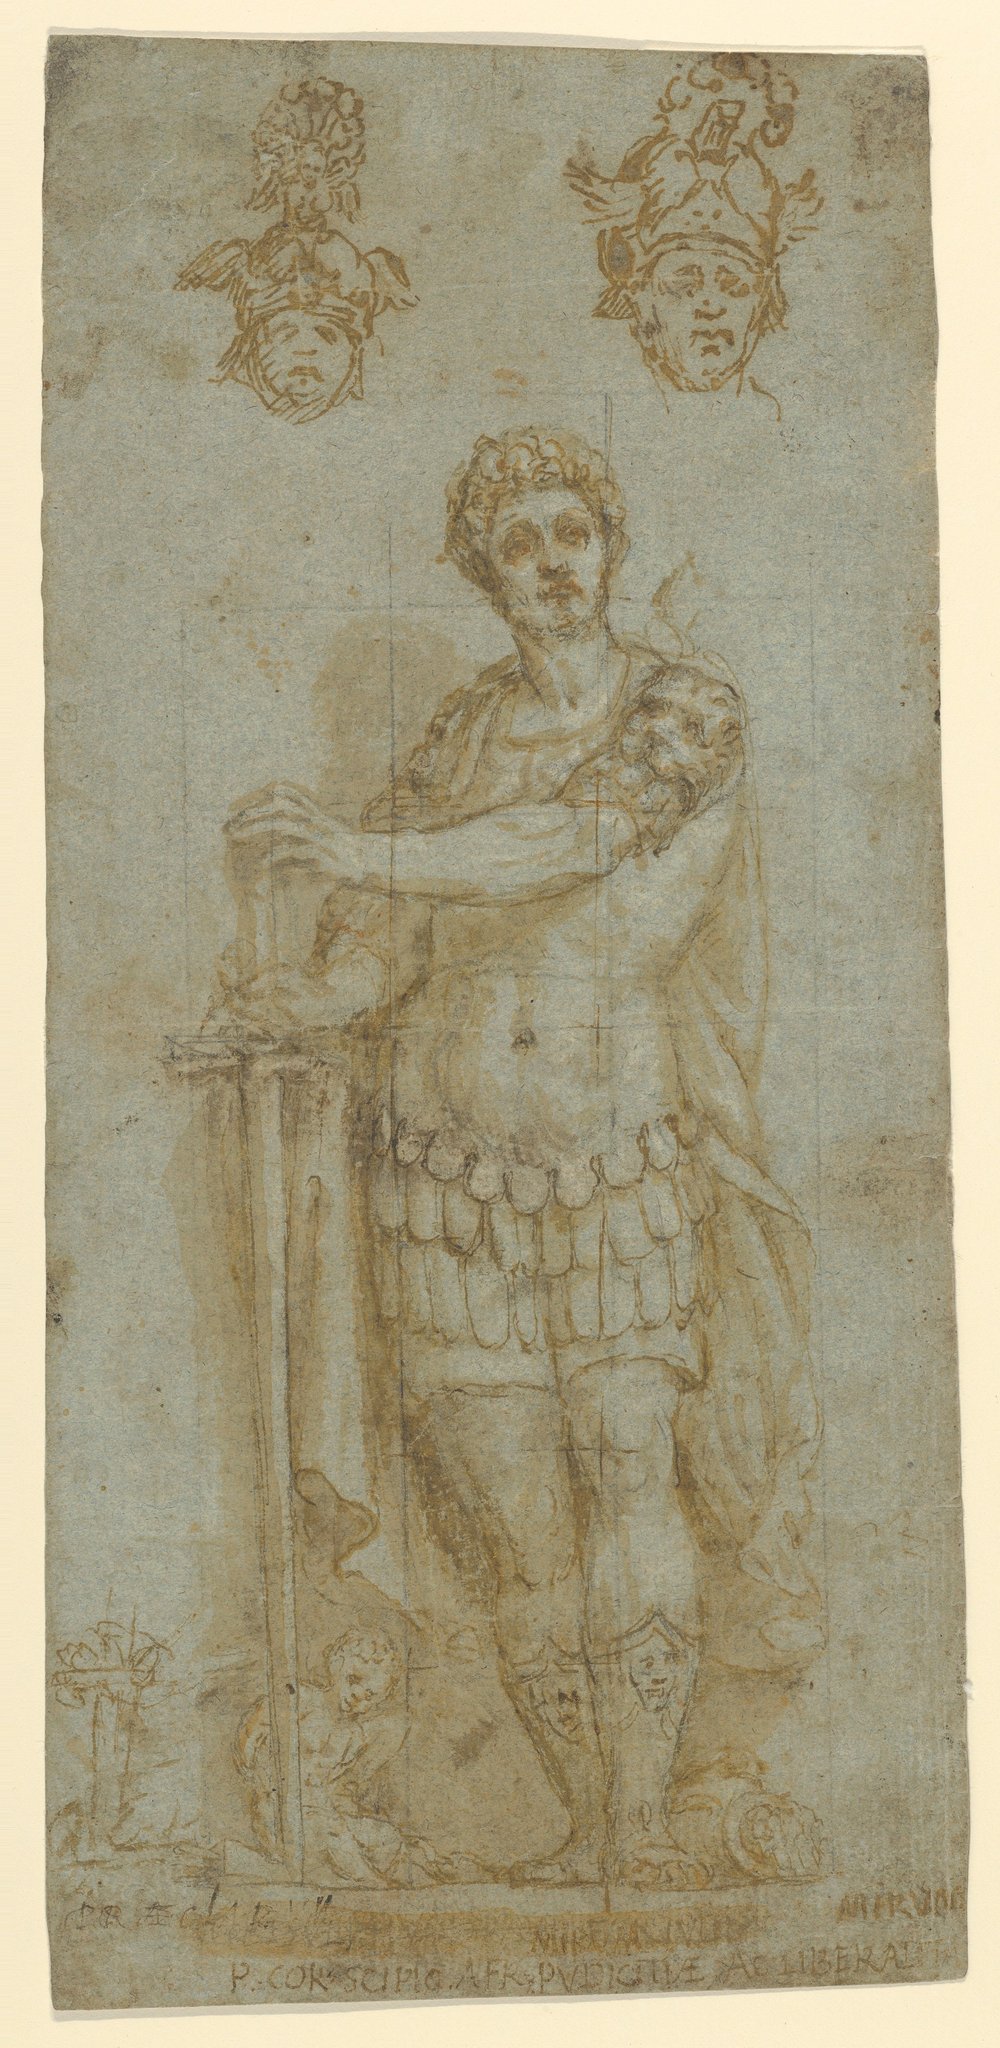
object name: drawing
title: Figure in Roman Dress (Publius Cornelius Scipio Africanus) and Study of Two Helmets (recto); Sketches and Latin Inscription (verso)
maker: anonymous, italian, 16th century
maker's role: artist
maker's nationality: italian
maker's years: 1500-1600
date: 1501-1600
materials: chalk, gouache, ink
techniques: brush, pen, drawing, wash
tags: dresses,swords,heads,men